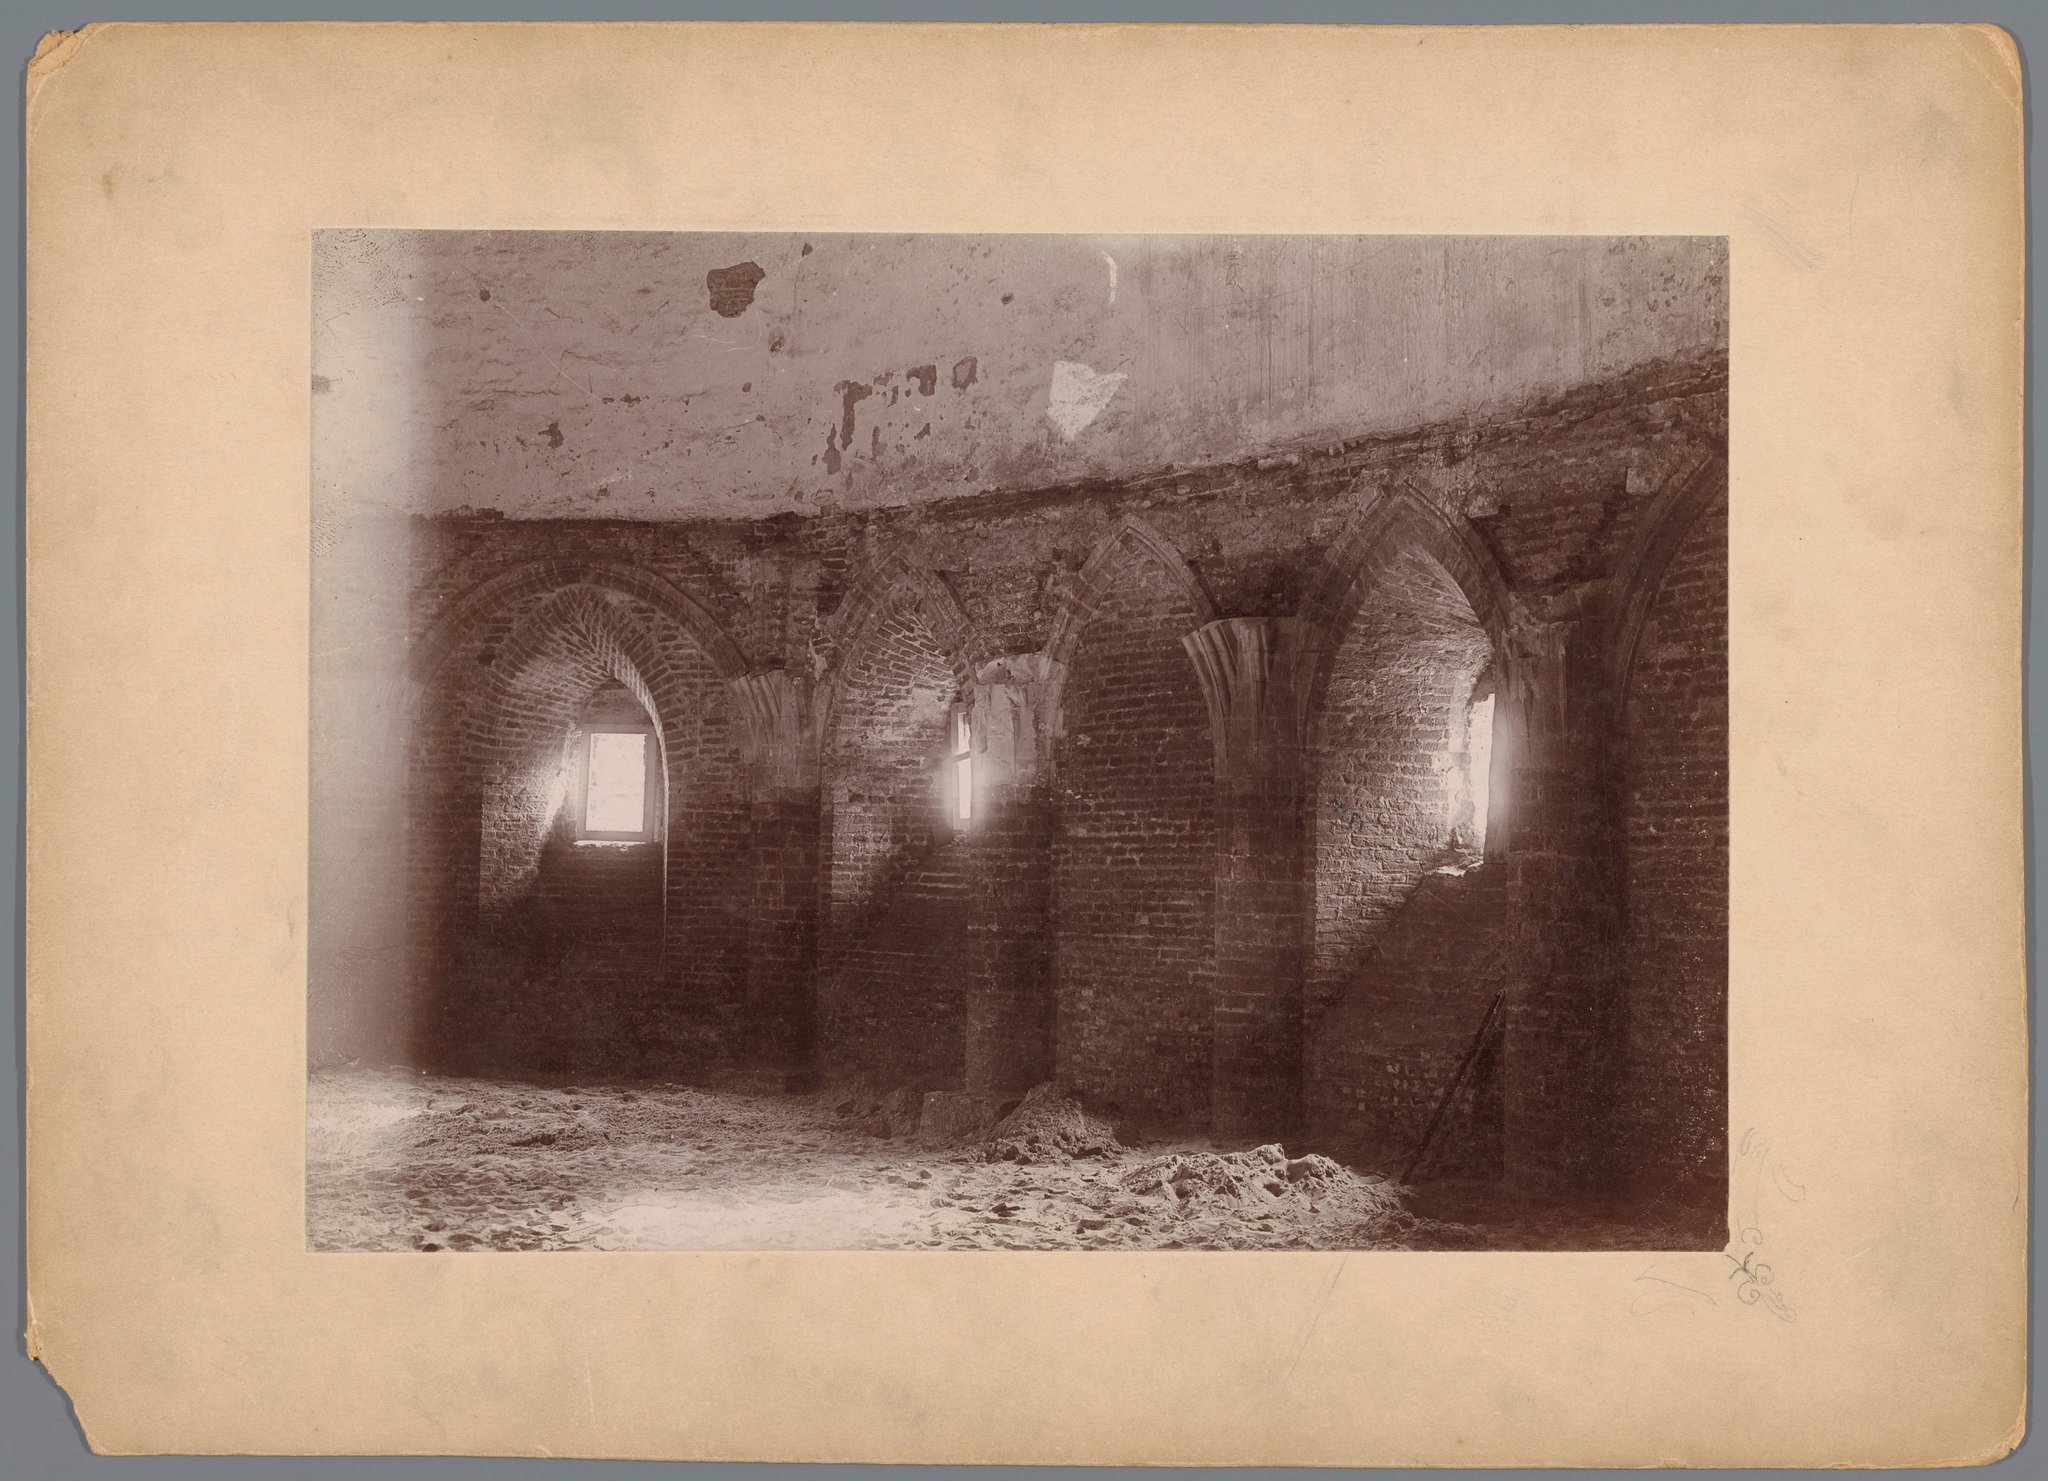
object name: photograph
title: Interieur van de crypte van de Geertruidskerk te Geertruidenberg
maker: Anonymous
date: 1875-1900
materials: cardboard, photographic support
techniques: daylight paper print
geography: geertruidenberg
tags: parts of church interior, parts of church interior (crypt), geertruidenberg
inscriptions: collector's mark: Lugt 3937, inscription: ‘Geertruidenberg Z.O. Hoek van de ontgraven krochten in de R K kerk’